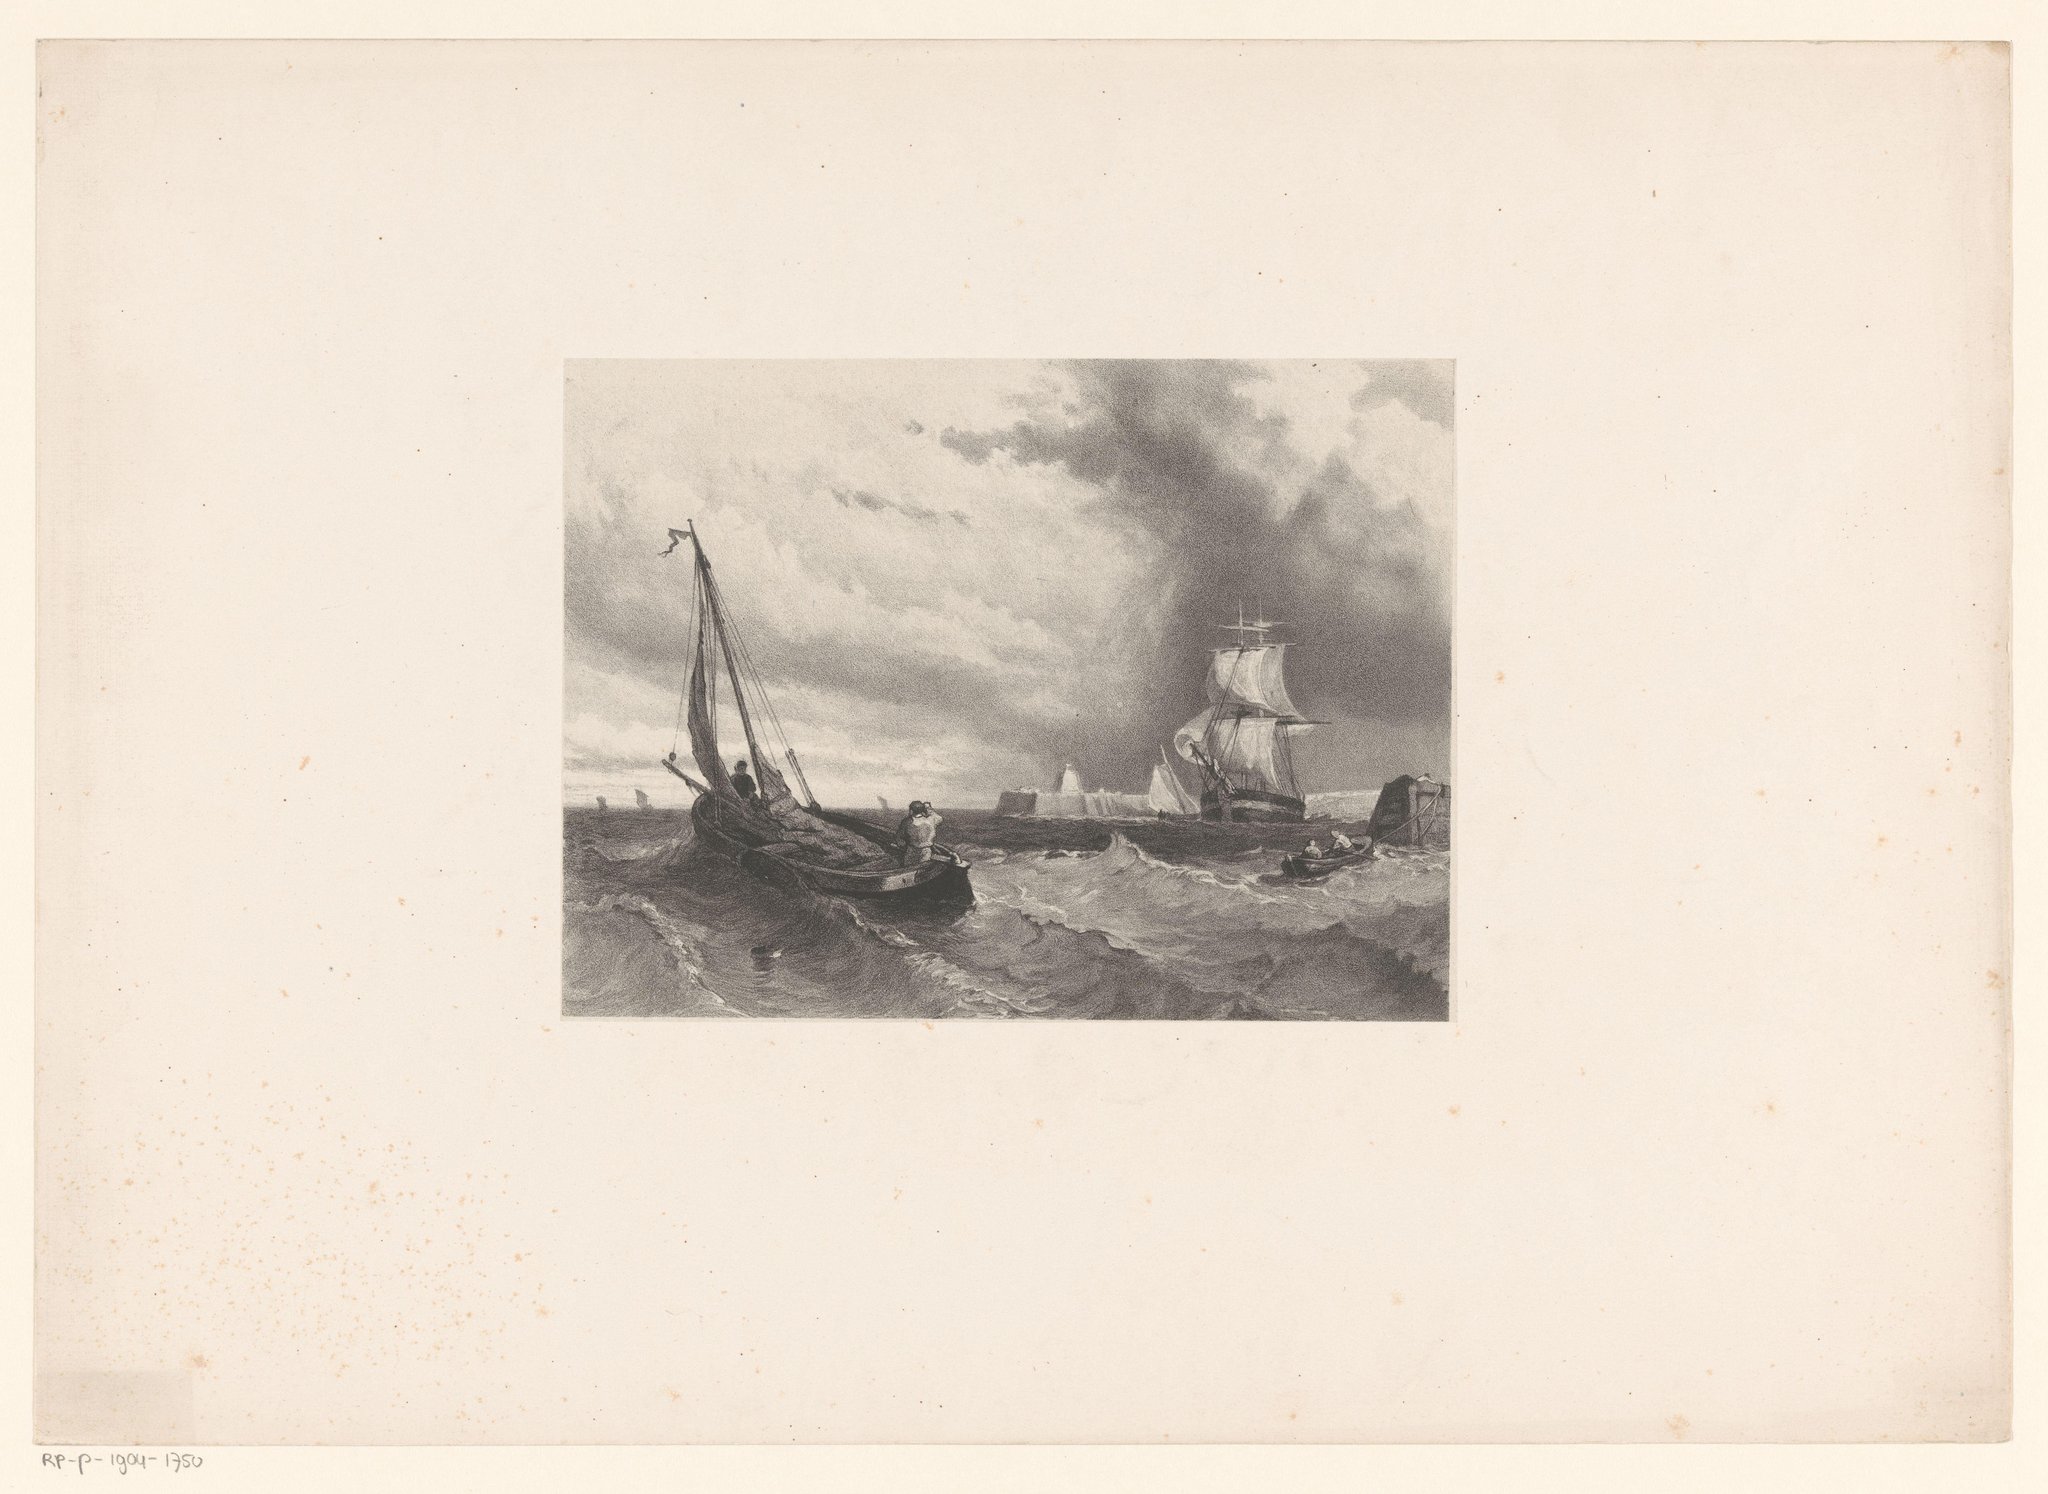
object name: print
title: Zeegezicht met haven en verschillende boten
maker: Anonymous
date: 1809-1899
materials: paper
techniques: lithograph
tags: harbour, sailing-ship, sailing-boat, rowing-boat, canoe, etc.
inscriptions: collector's mark: Lugt 2228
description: Een botter zeilt de haven uit. Verderop vaart een fregat. Aan het voorste havenhoofd ligt een vlet aangemeerd met twee figuren.